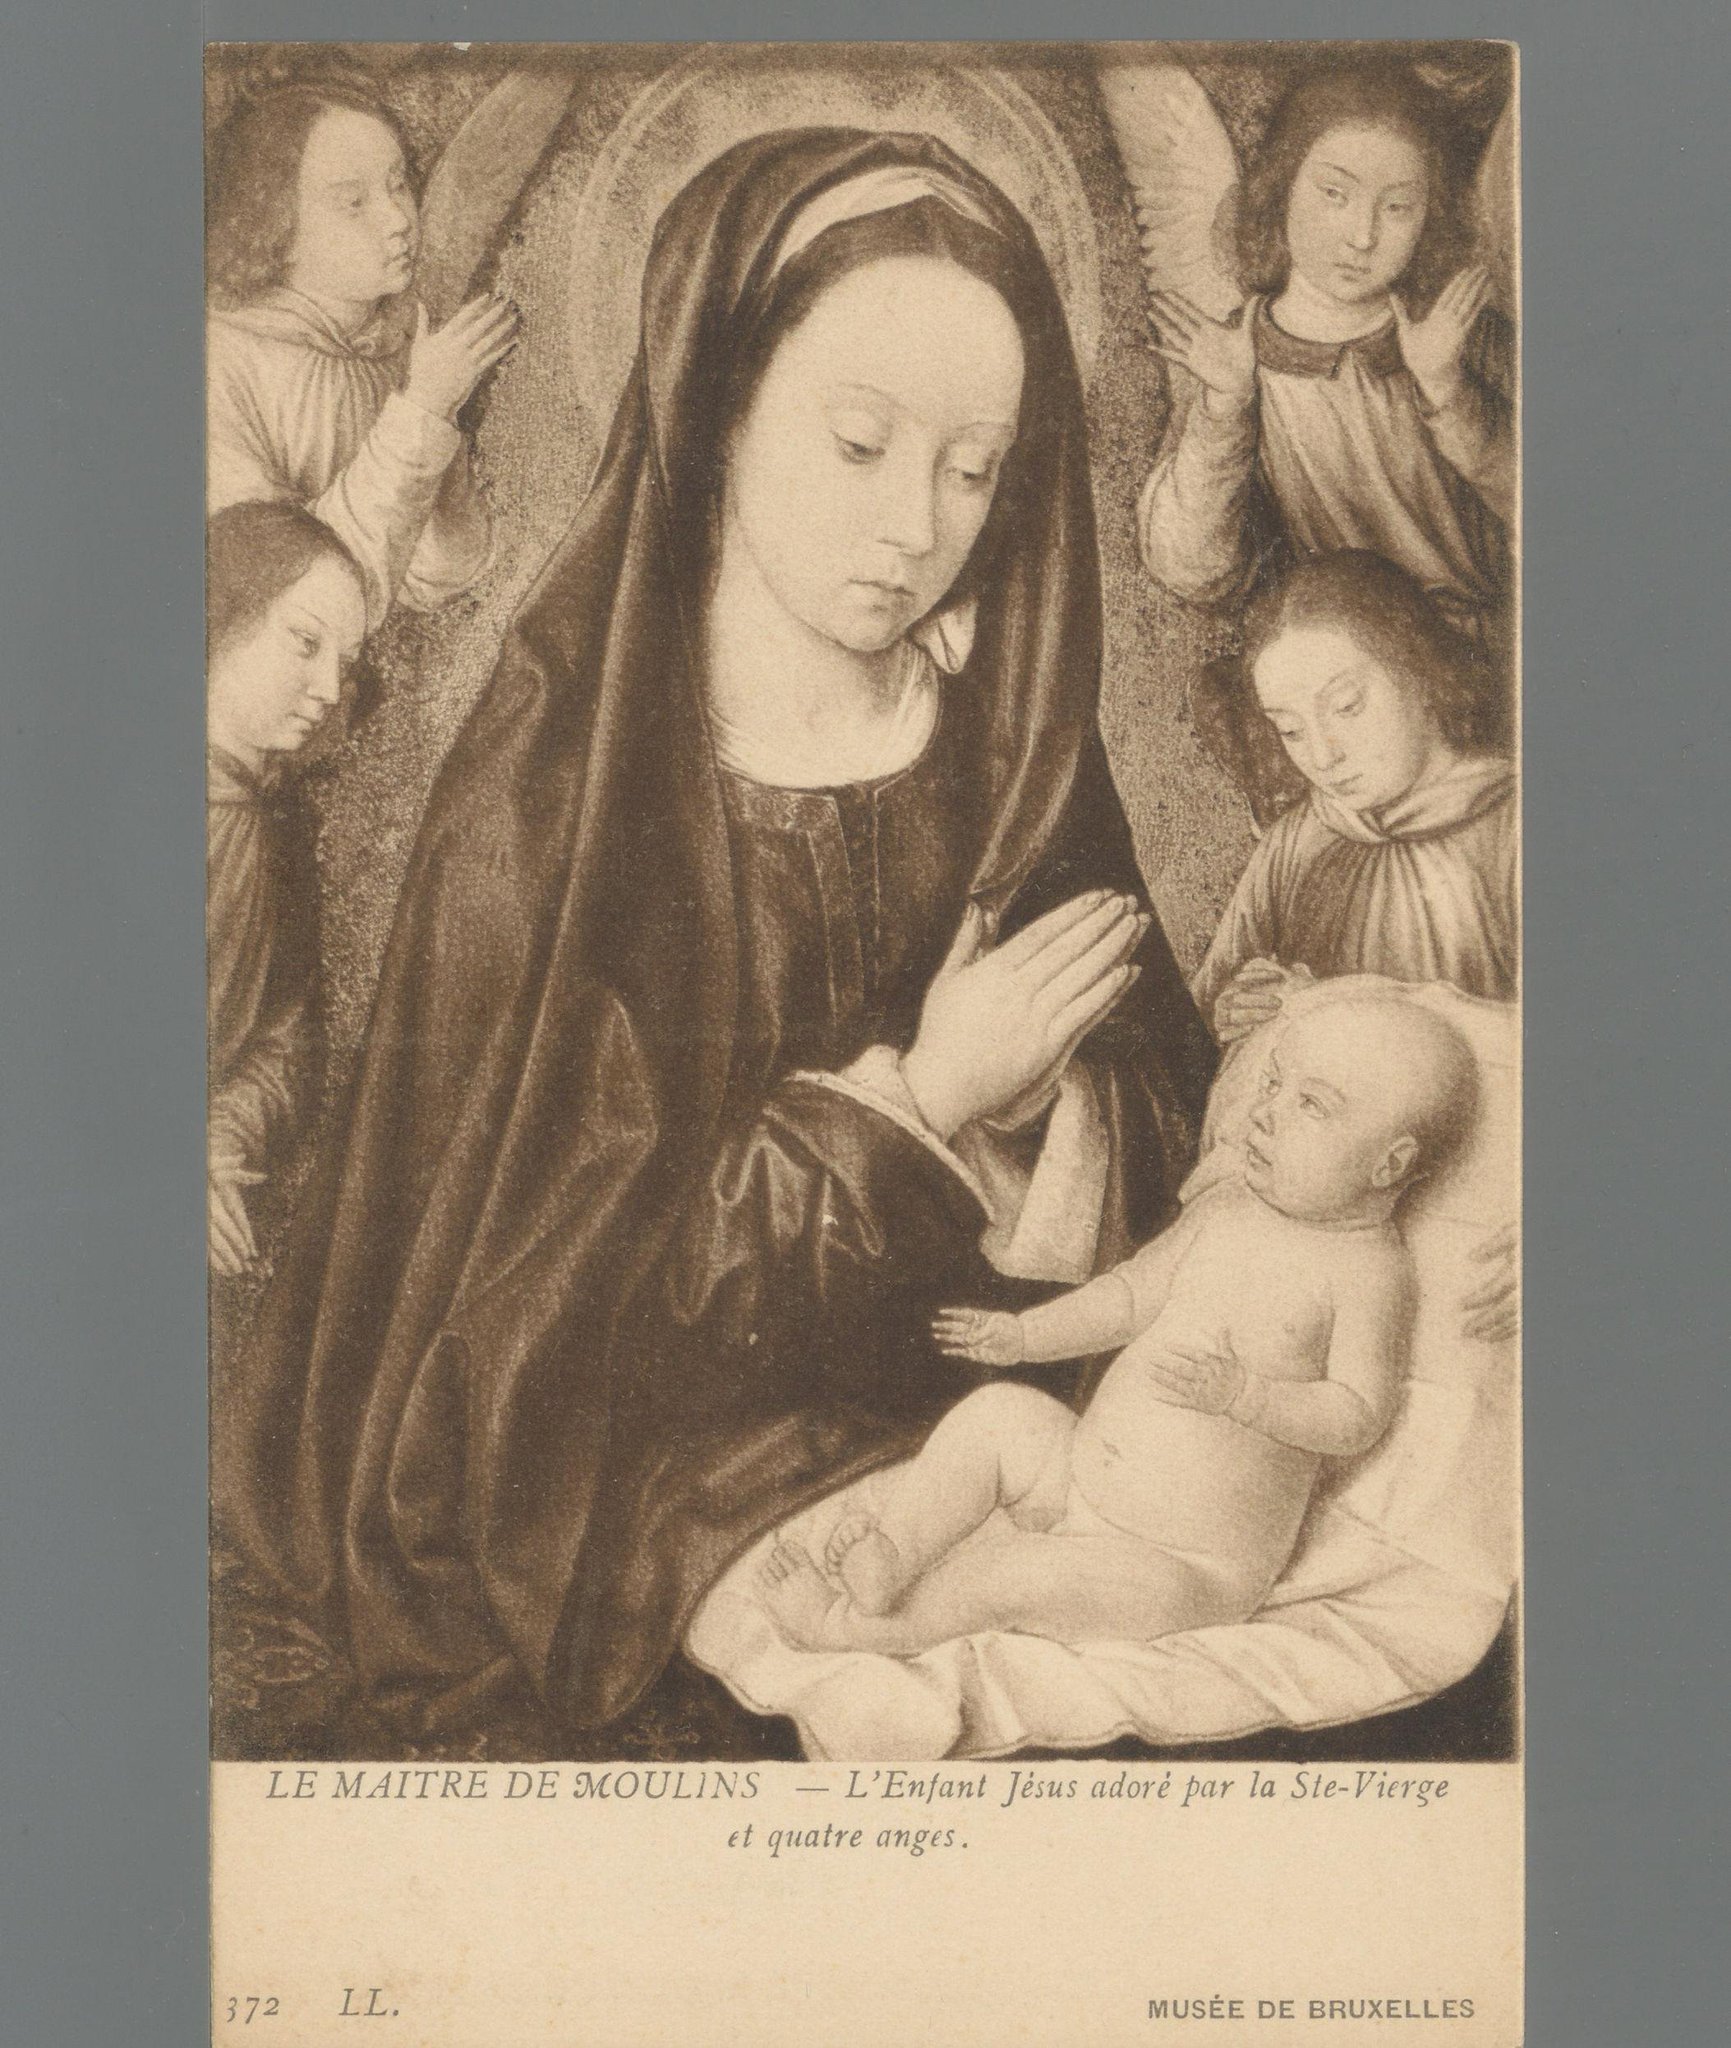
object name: photomechanical print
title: Le maitre de moulins - L'Enfant Jésus adoré par la Ste-Vierge et quatre anges. Musée de Bruxelles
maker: Anonymous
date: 1903-1932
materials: cardboard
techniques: photograph, writing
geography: paris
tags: permanent exhibition, museum, picture, painting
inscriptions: collector's mark: ‘AFE v S’